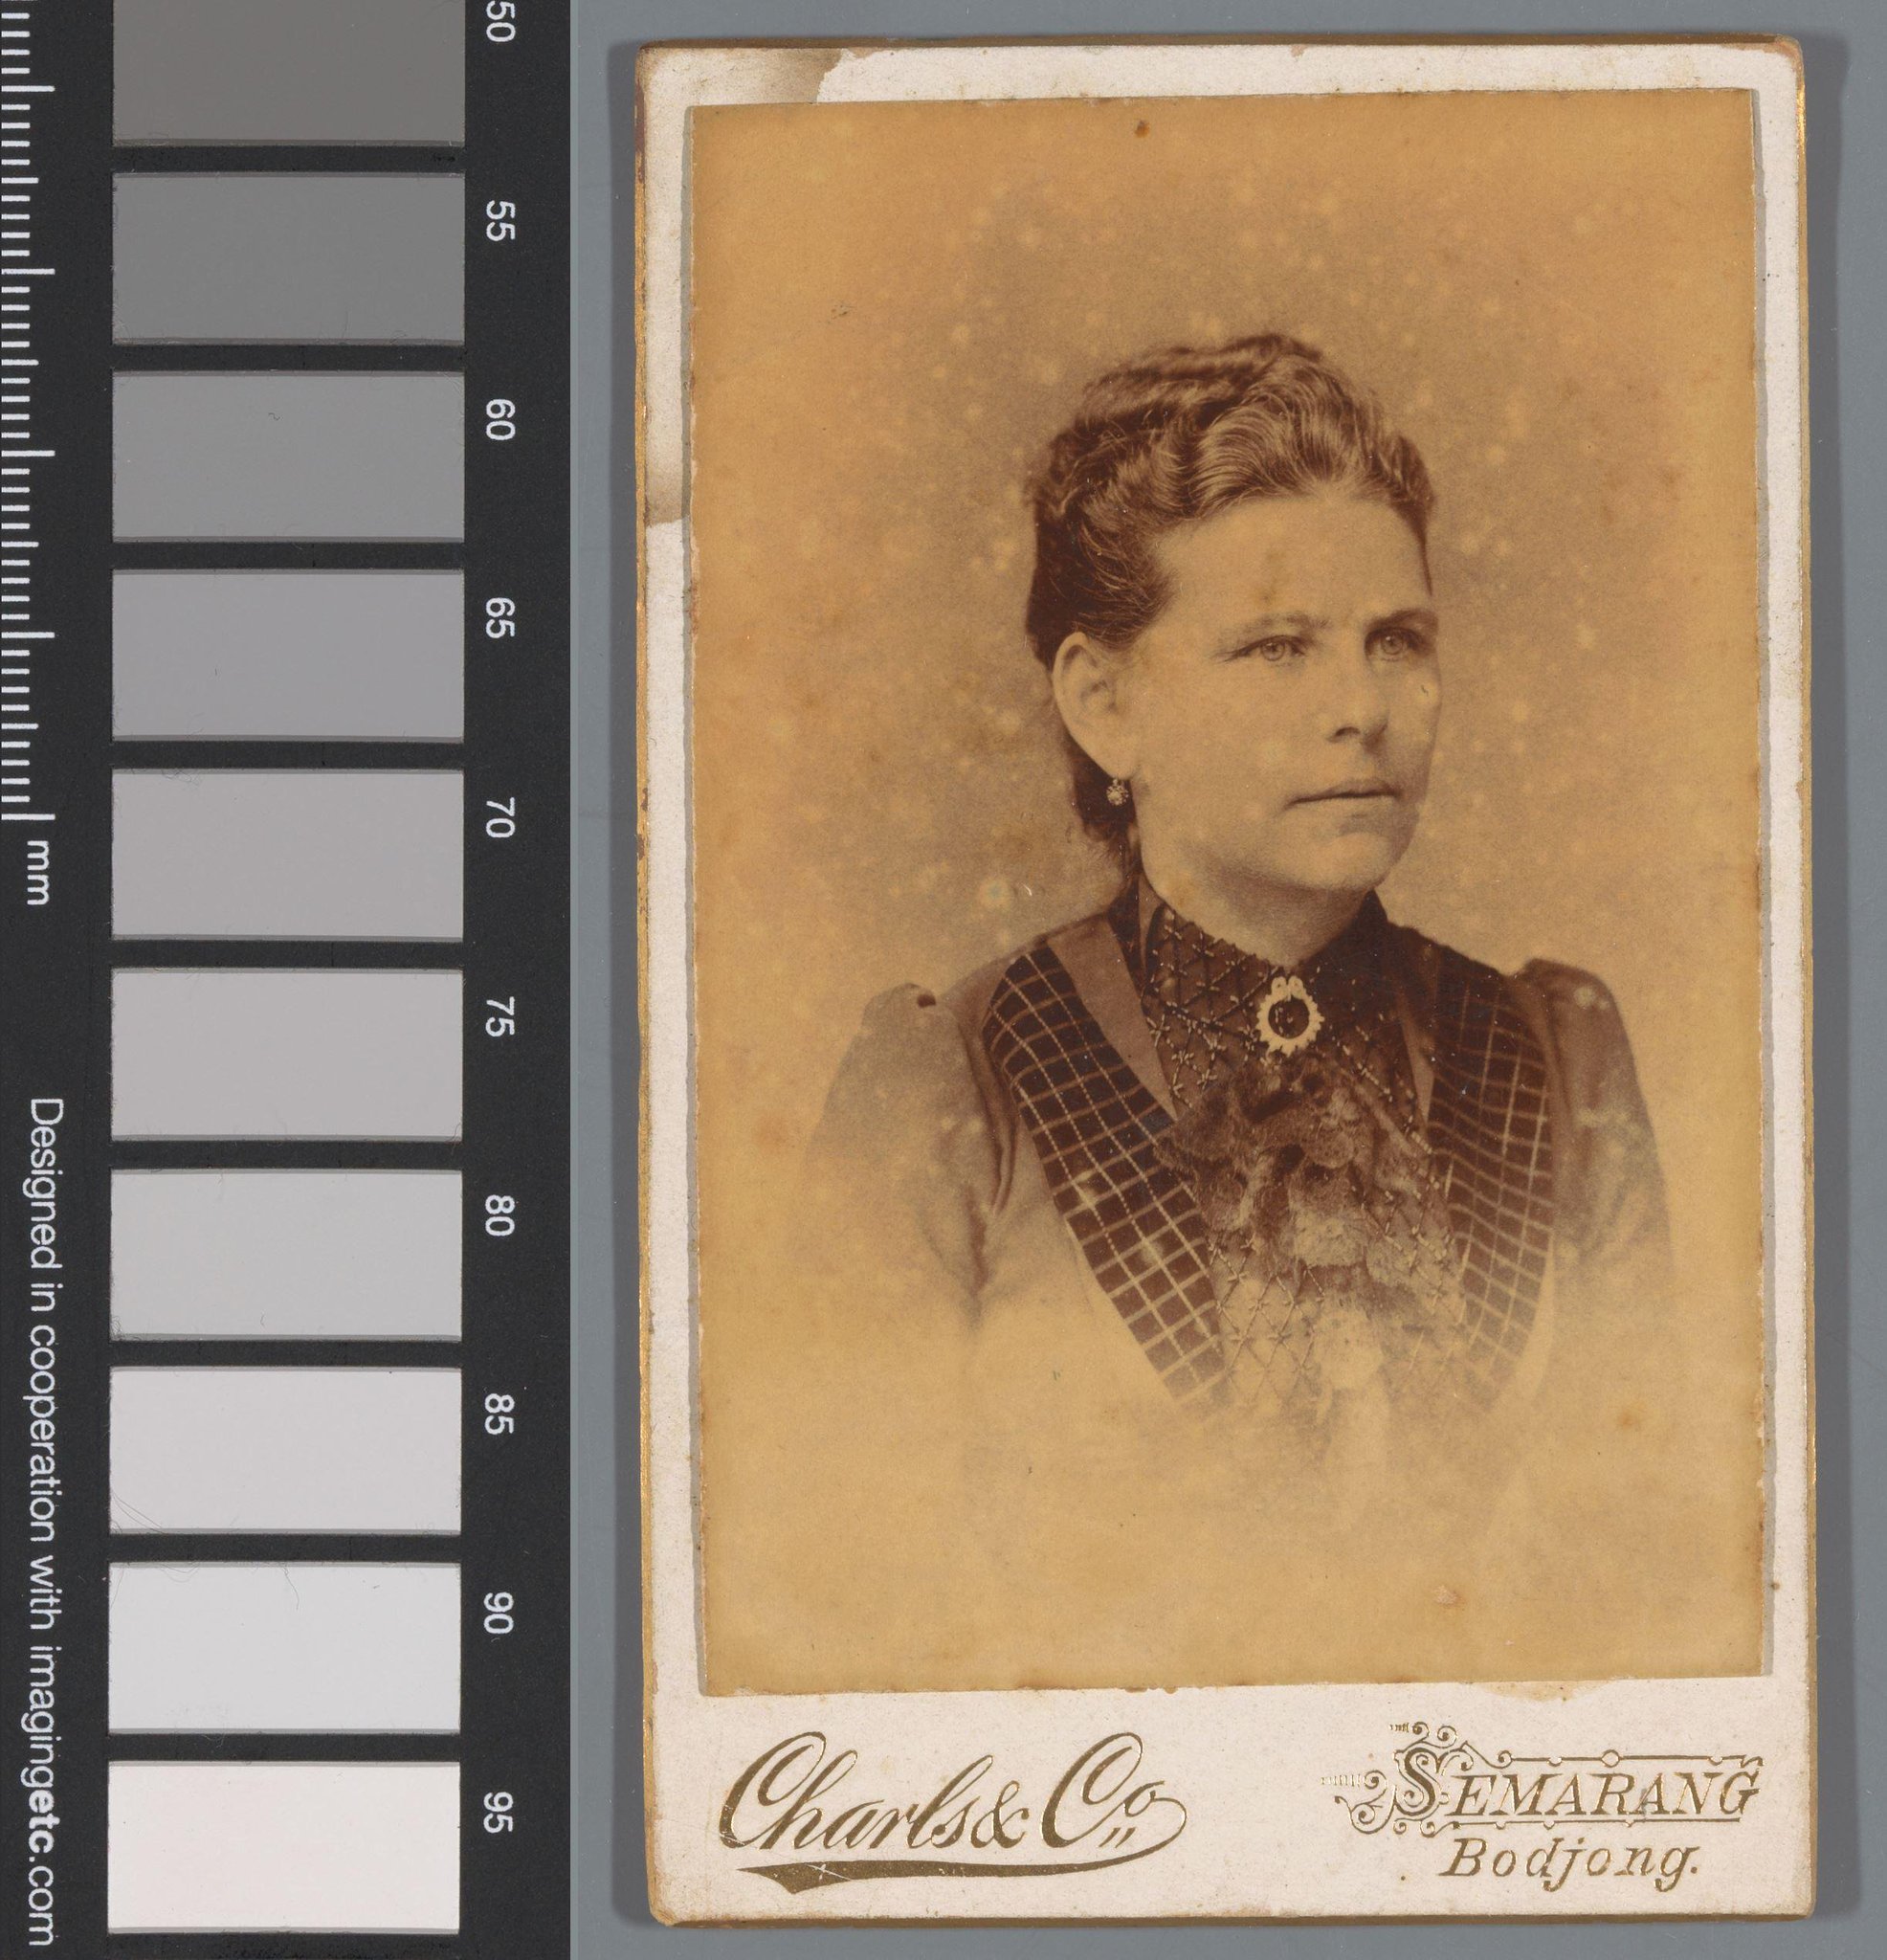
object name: photograph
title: Portret van een onbekende vrouw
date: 1888-1910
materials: cardboard, paper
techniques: albumen print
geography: semarang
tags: adult woman, anonymous historical person portrayed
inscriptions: inscription: ‘Het cliché wordt/ voor nabestelling bewaard./ Reg. C.E. & C.’, inscription: ‘Charls & Co/ Semarang/ Bodjong.’